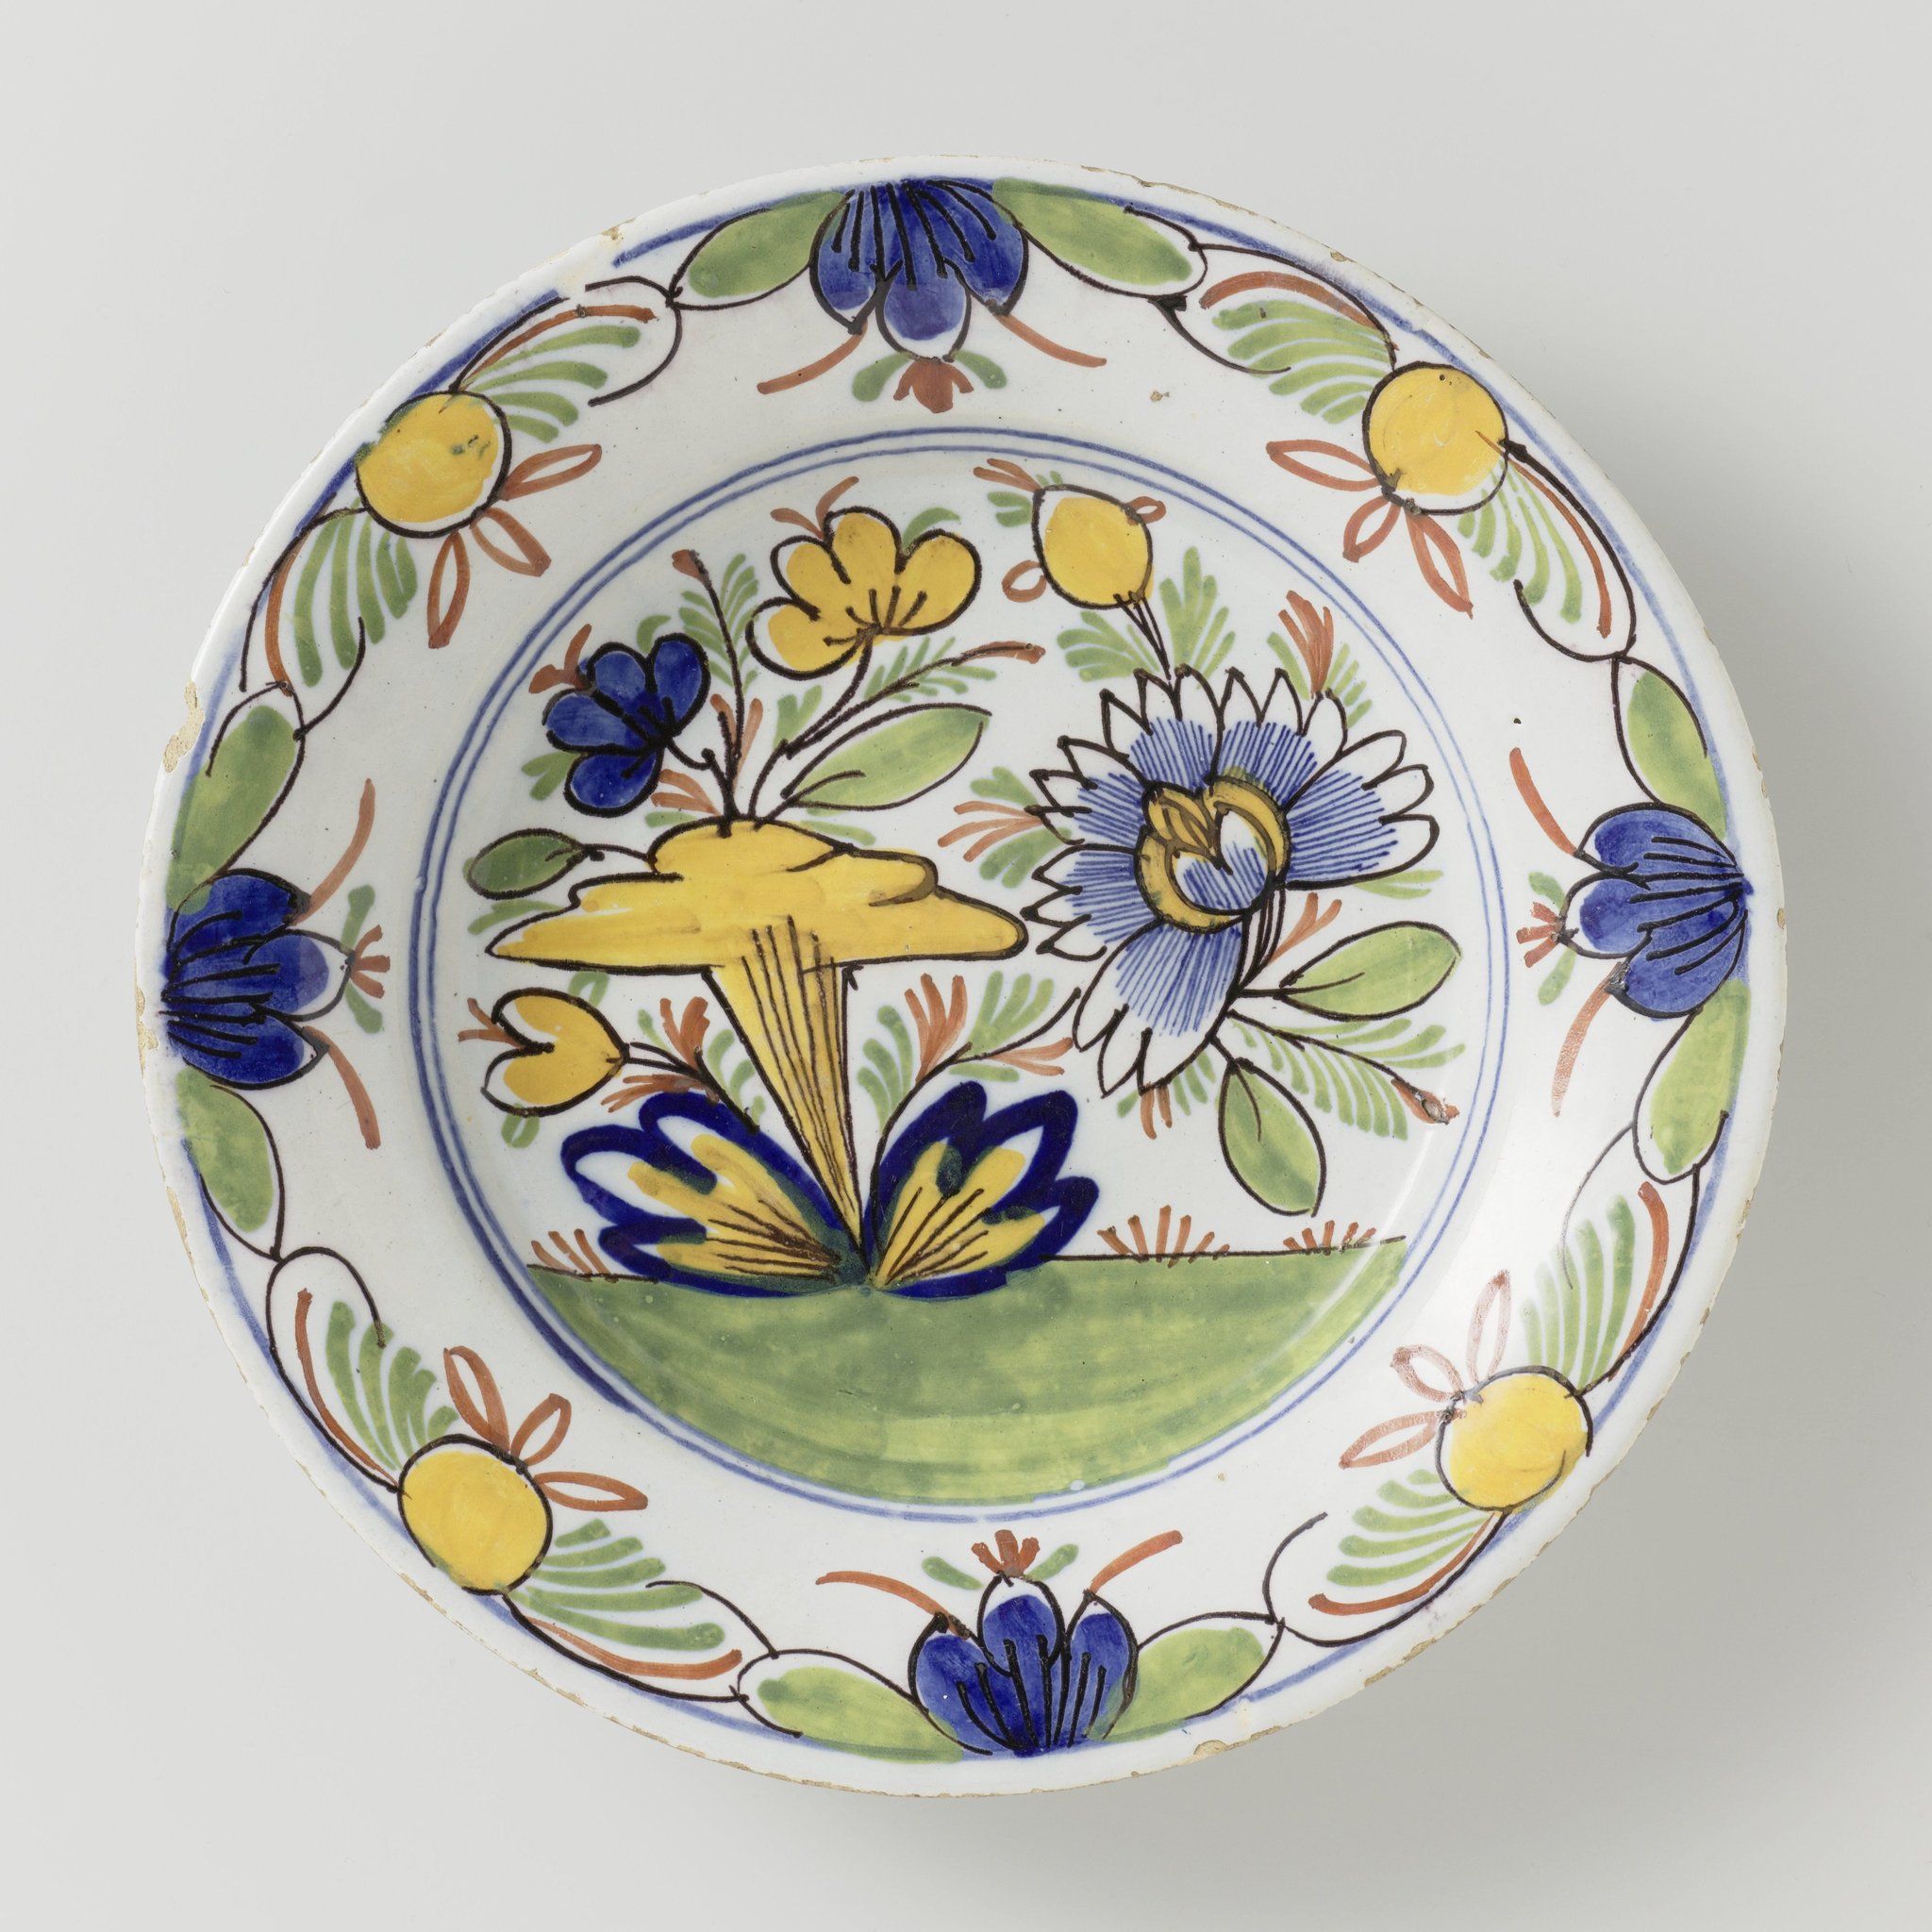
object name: plate dish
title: Bord van veelkleurig beschilderde faience met bloemdecoratie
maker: Anonymous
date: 1750-1790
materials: earthenware, glaze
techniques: painted, polychromy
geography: delft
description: Rond bord van veelkleurig beschilderde faience. Op het plat zijn bloemen op een grond en op de rand gestileerde bloemen geschilderd in de kleuren geel, blauw, groen, rood en paars. Bij het bord horen twee identieke borden met invnr. BK-NM-13346-e en BK-NM-13346-f.